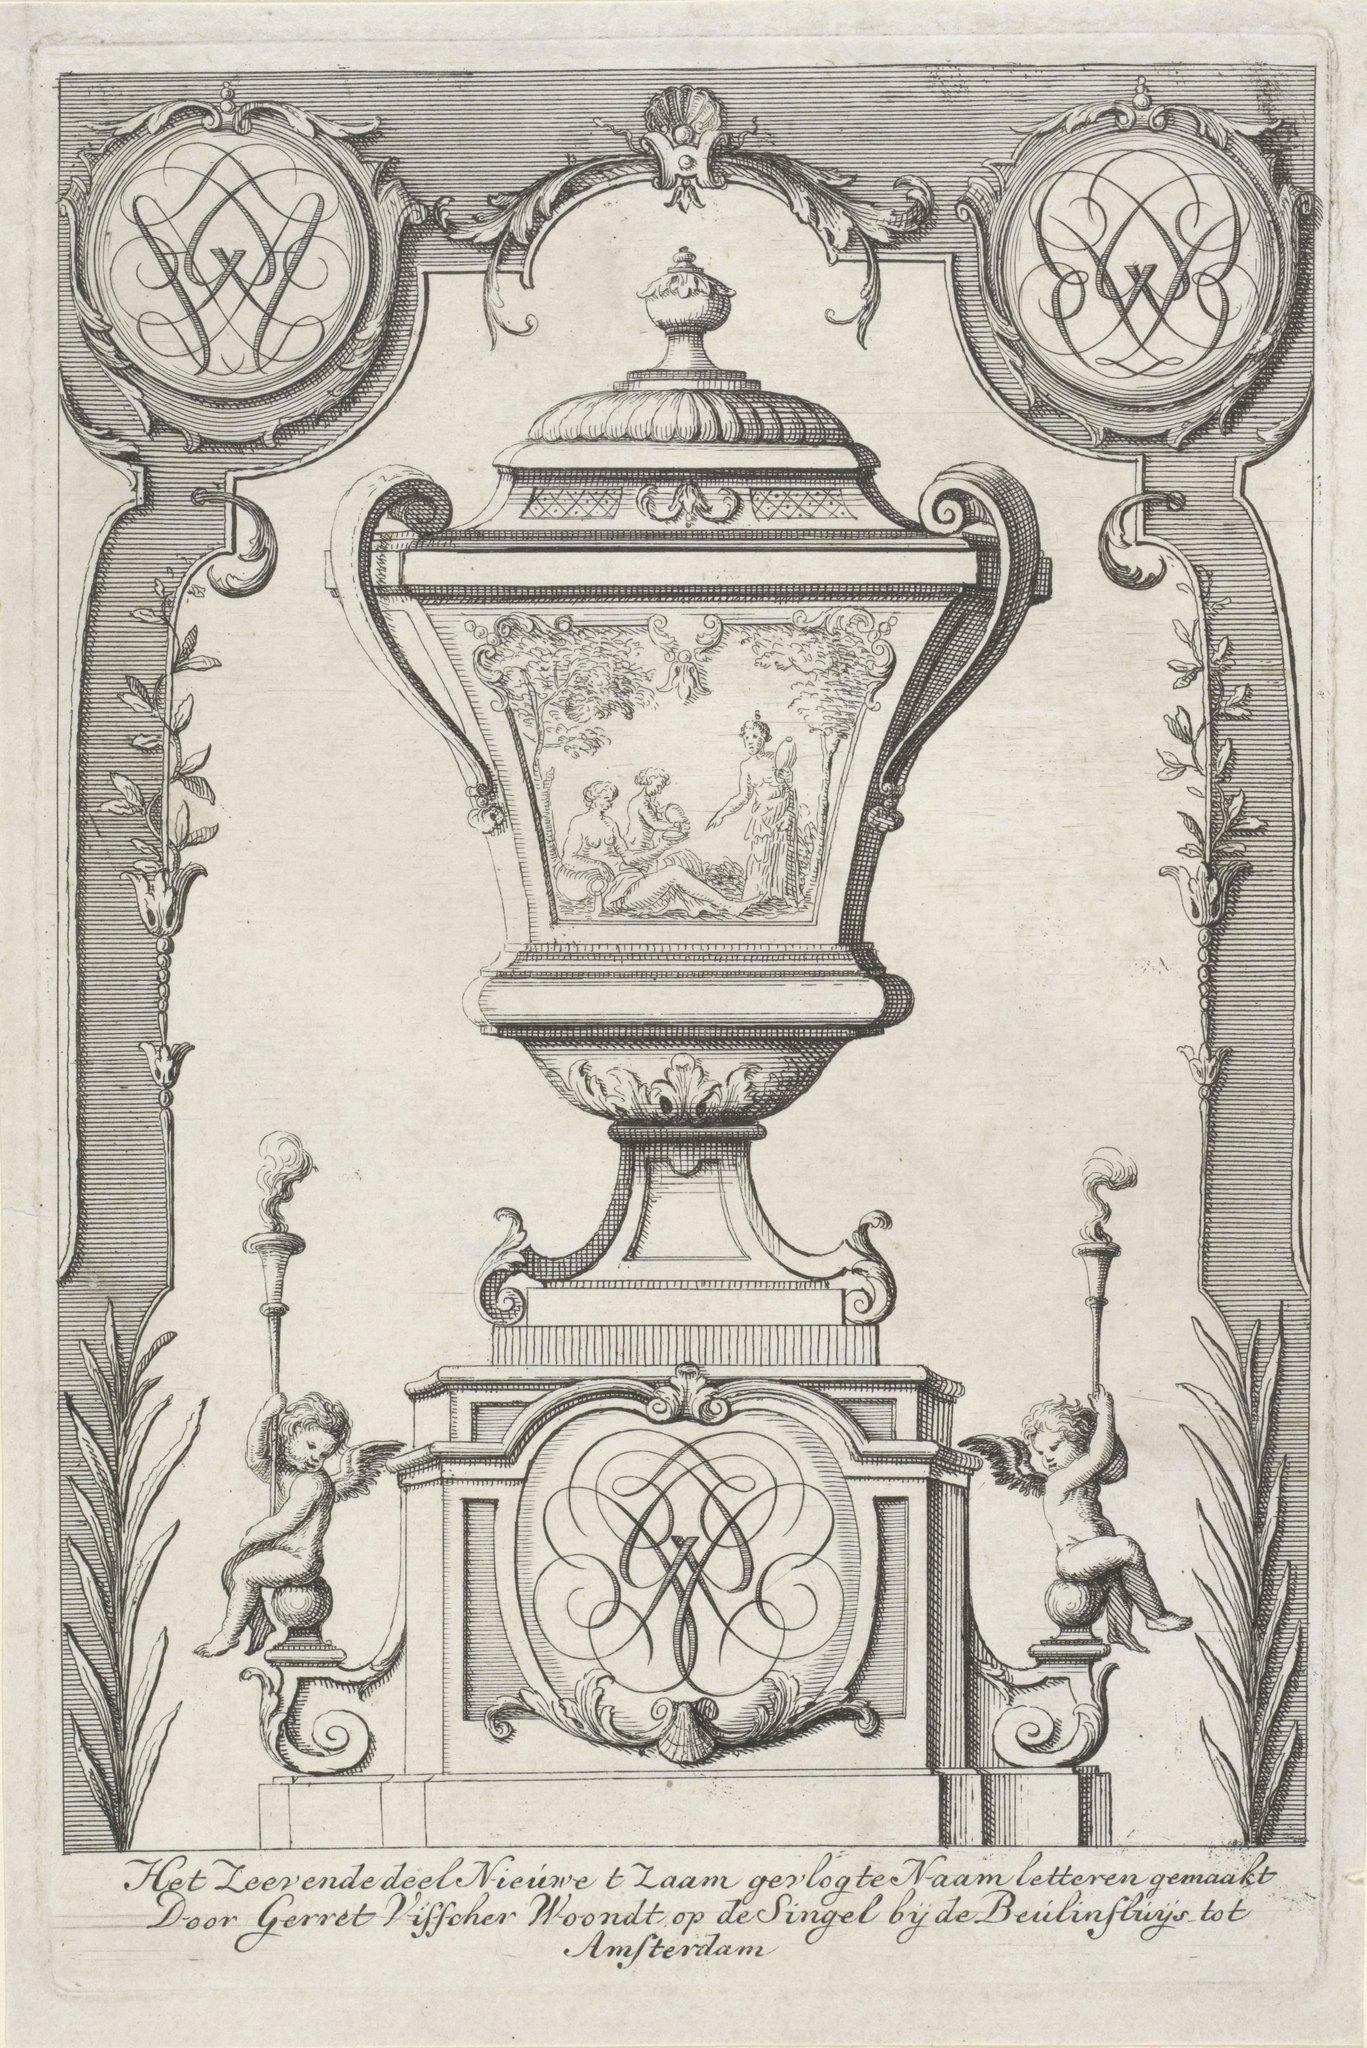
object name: print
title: Het Zeevende deel Nieuwe t Zaam gevlogte Naam letteren gemaakt Door Gerret Visscher Woondt op de Singel bij de Beulinsluijs tot Amsterdam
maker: gerrit visscher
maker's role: print maker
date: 1690-1710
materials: paper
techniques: engraving, etching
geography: amsterdam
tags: ornaments ~ art, garden vase, letter combinations such as letterword, anagram, letter square, monogram, etc.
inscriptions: collector's mark: Lugt 2228